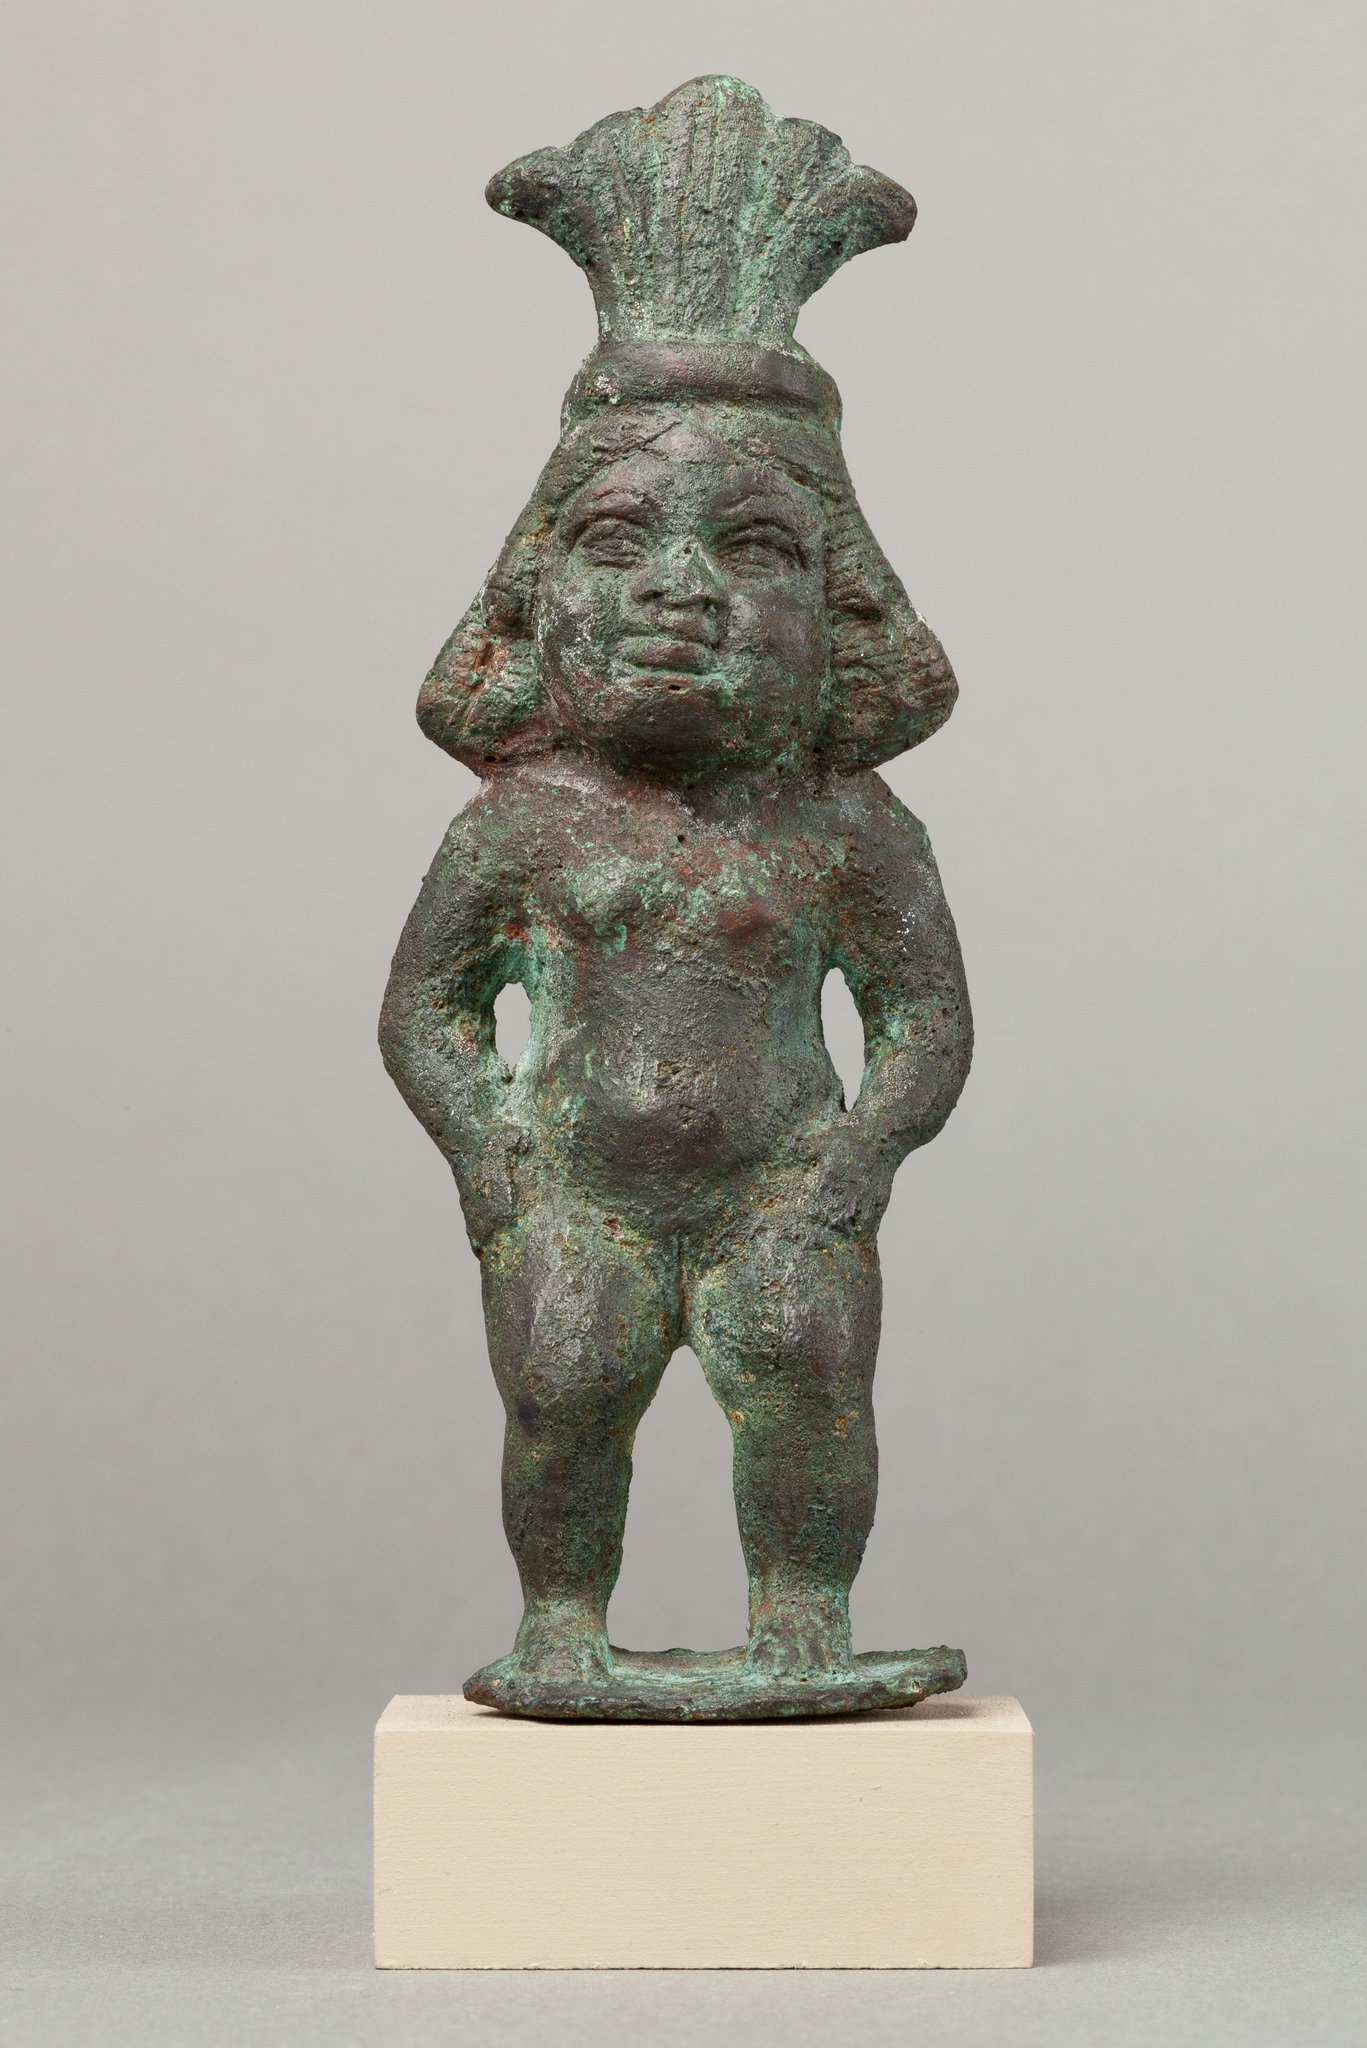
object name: statuette, beset besis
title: Statuette of Beset (Besis)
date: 664-630 BCE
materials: metal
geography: egypt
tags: women